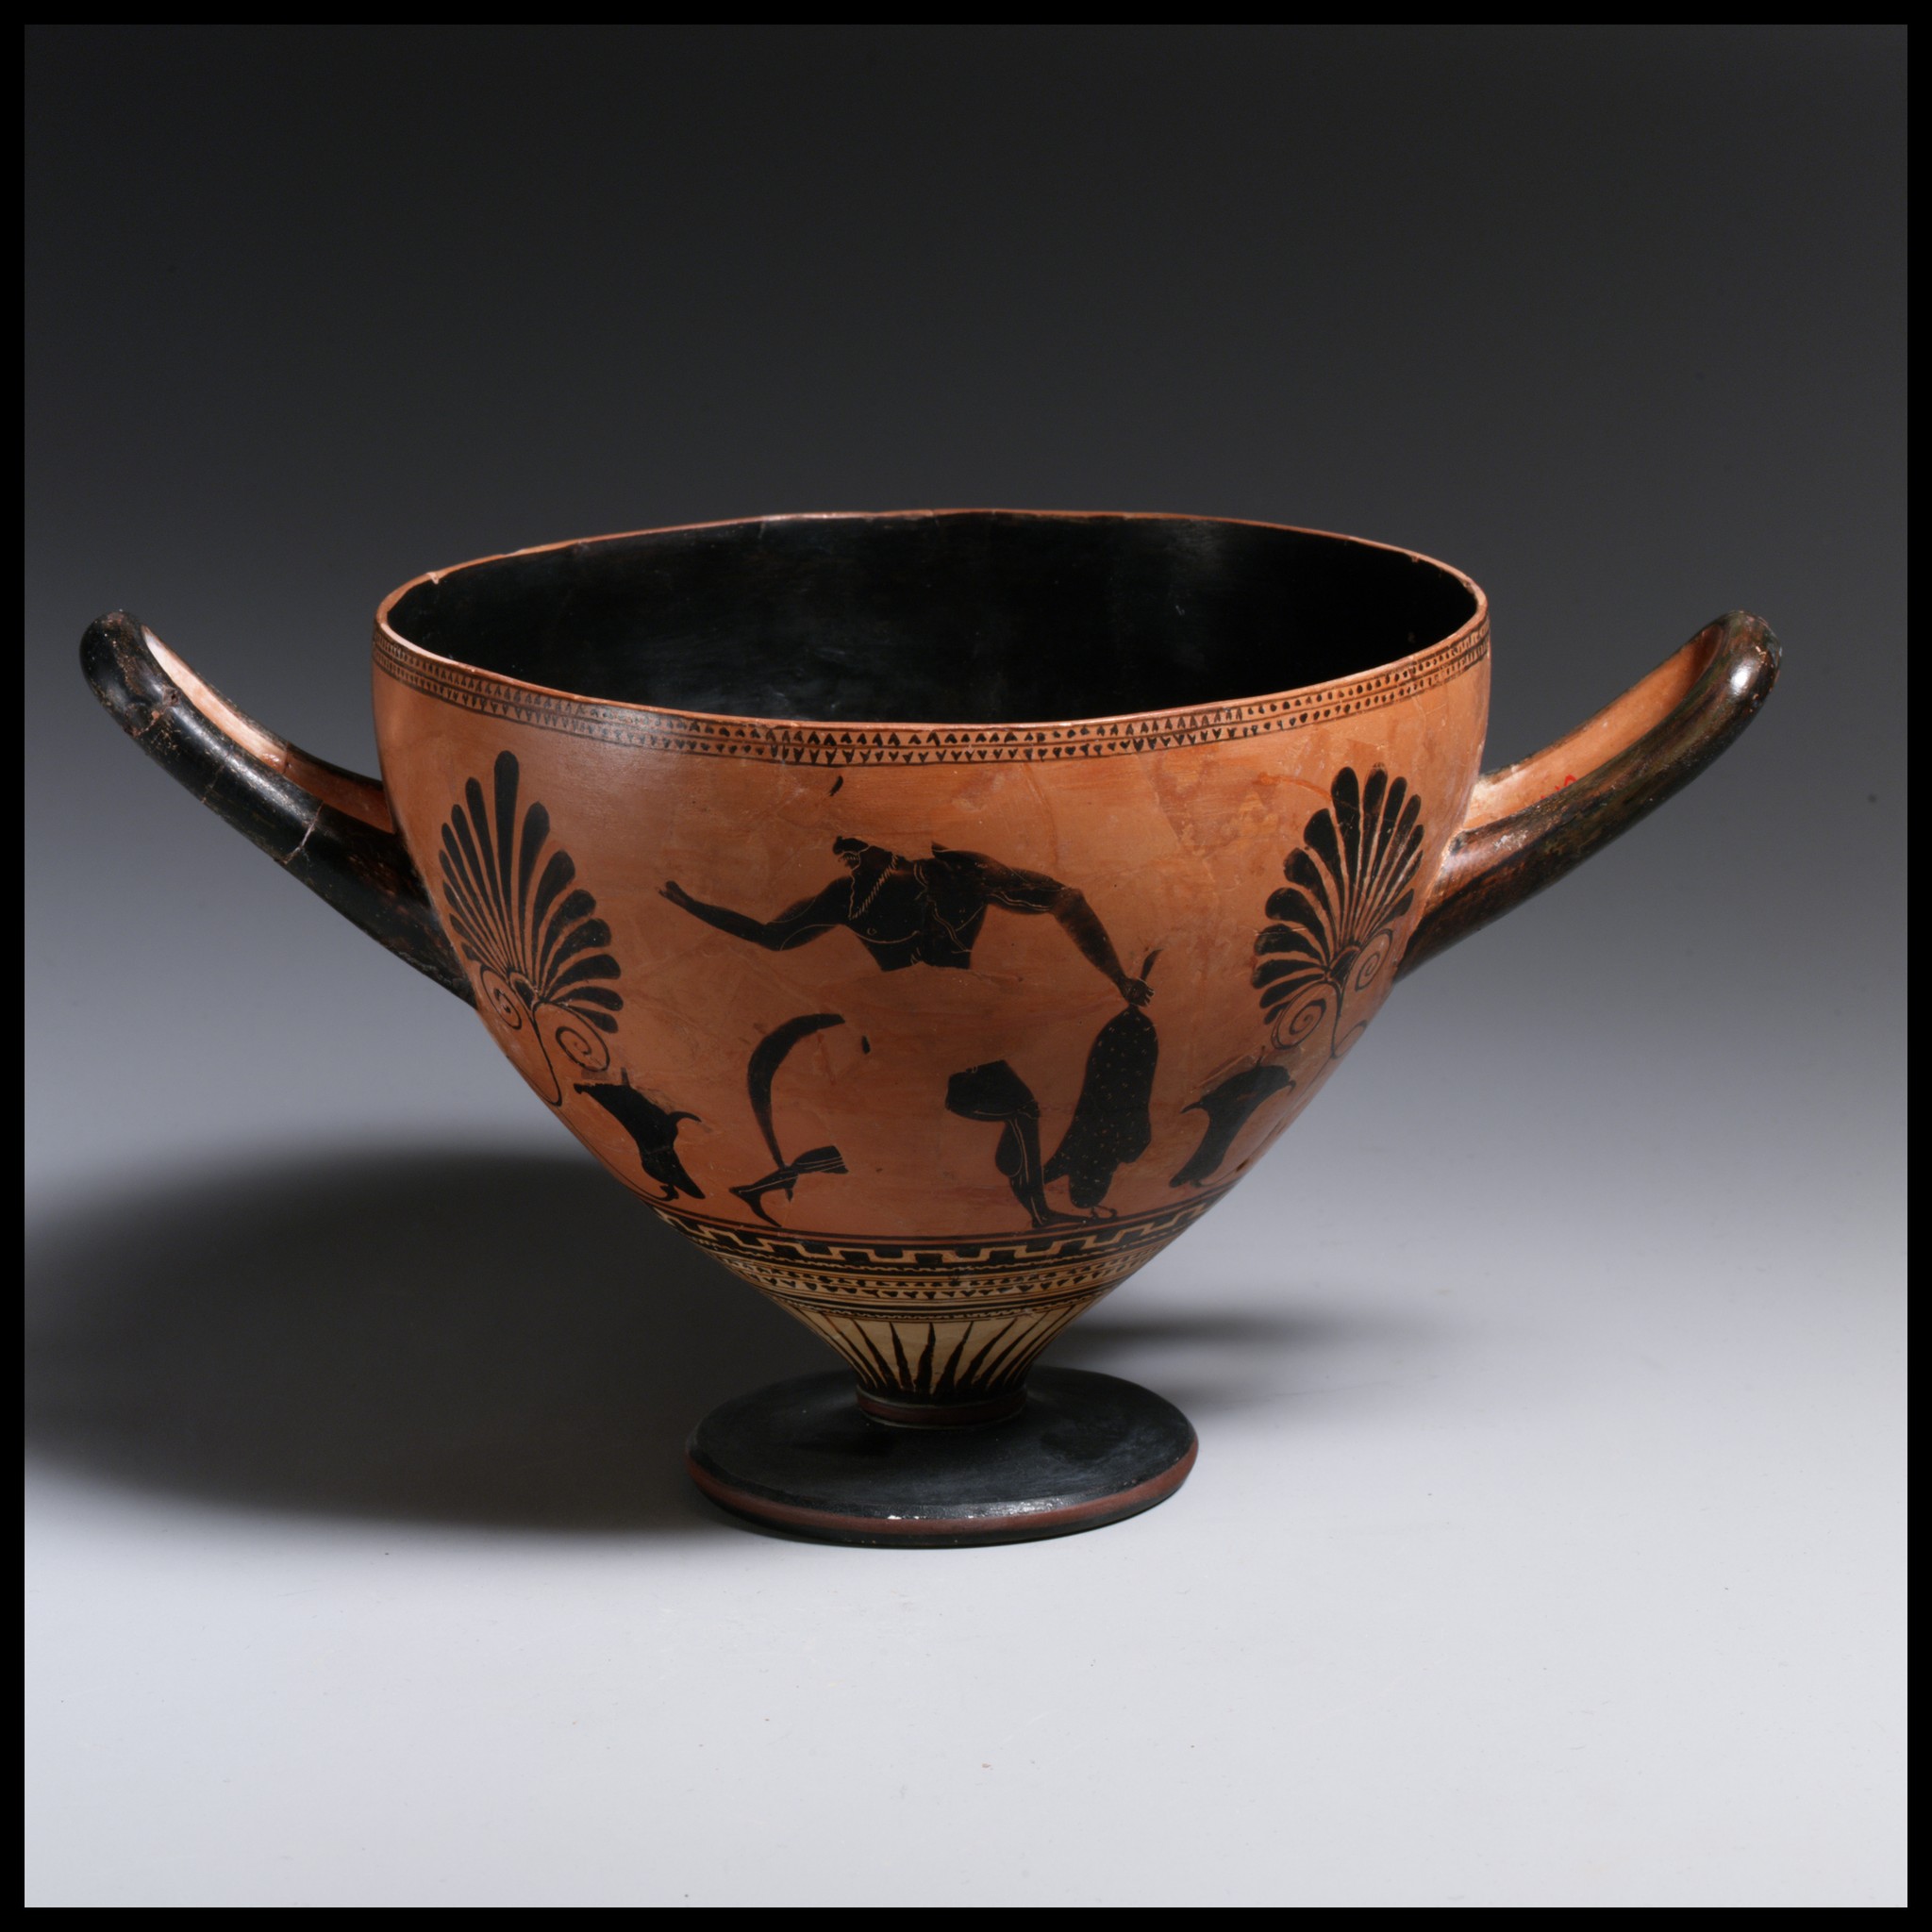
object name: skyphos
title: Terracotta skyphos (deep drinking cup)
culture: greek, attic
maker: psiax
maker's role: artist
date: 520-510 BCE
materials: terracotta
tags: satyrs